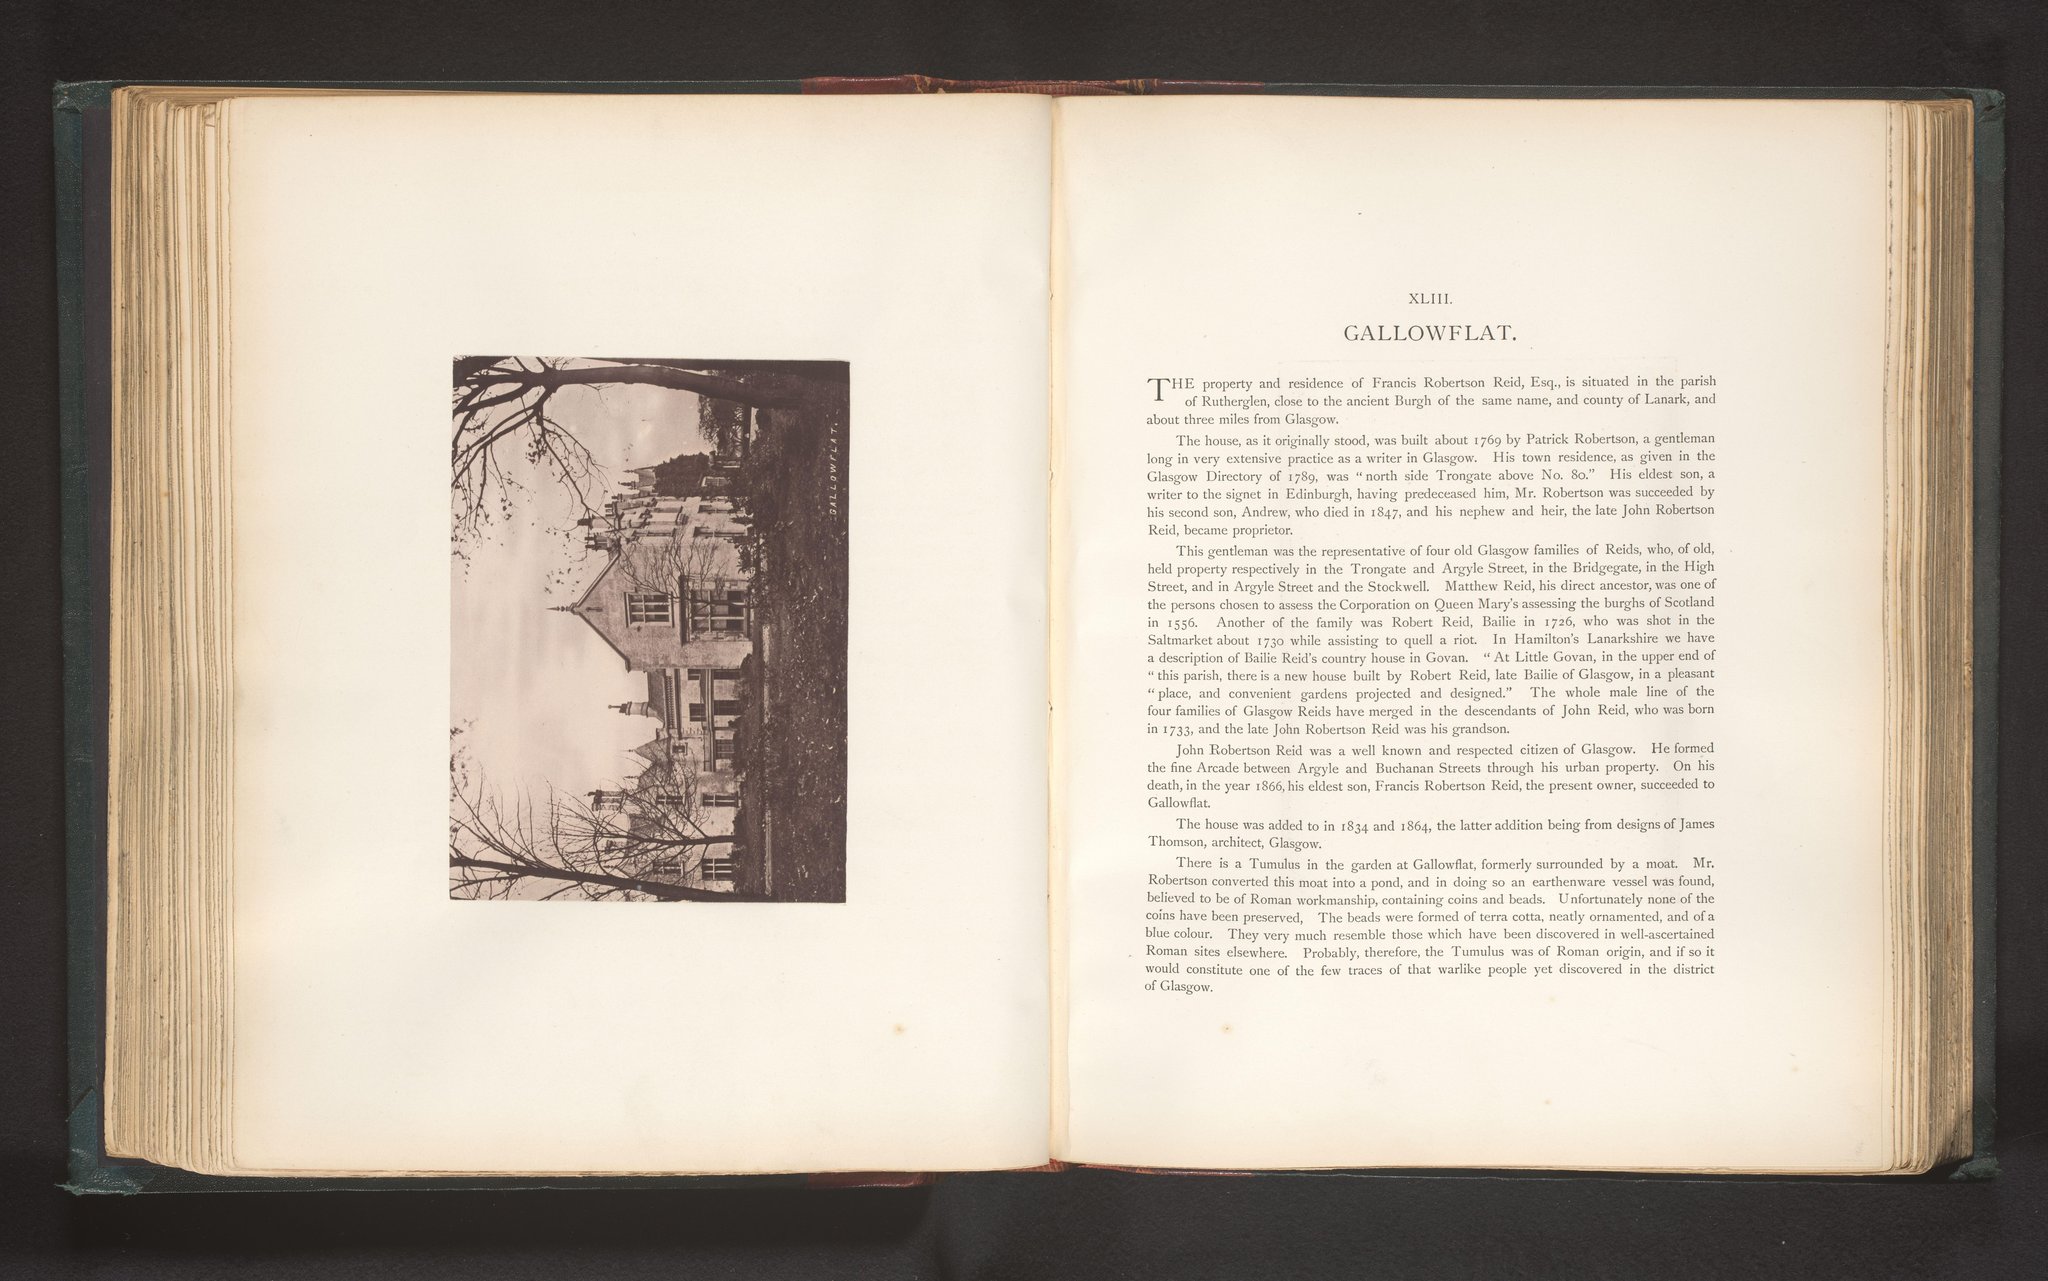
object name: photograph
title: Gallowflat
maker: thomas annan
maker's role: fotograaf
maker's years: 1829-1887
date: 1868-1878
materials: paper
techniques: carbon print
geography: rutherglen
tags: rural housing, e.g. country-house, villa, cottage, façade (of house or building)